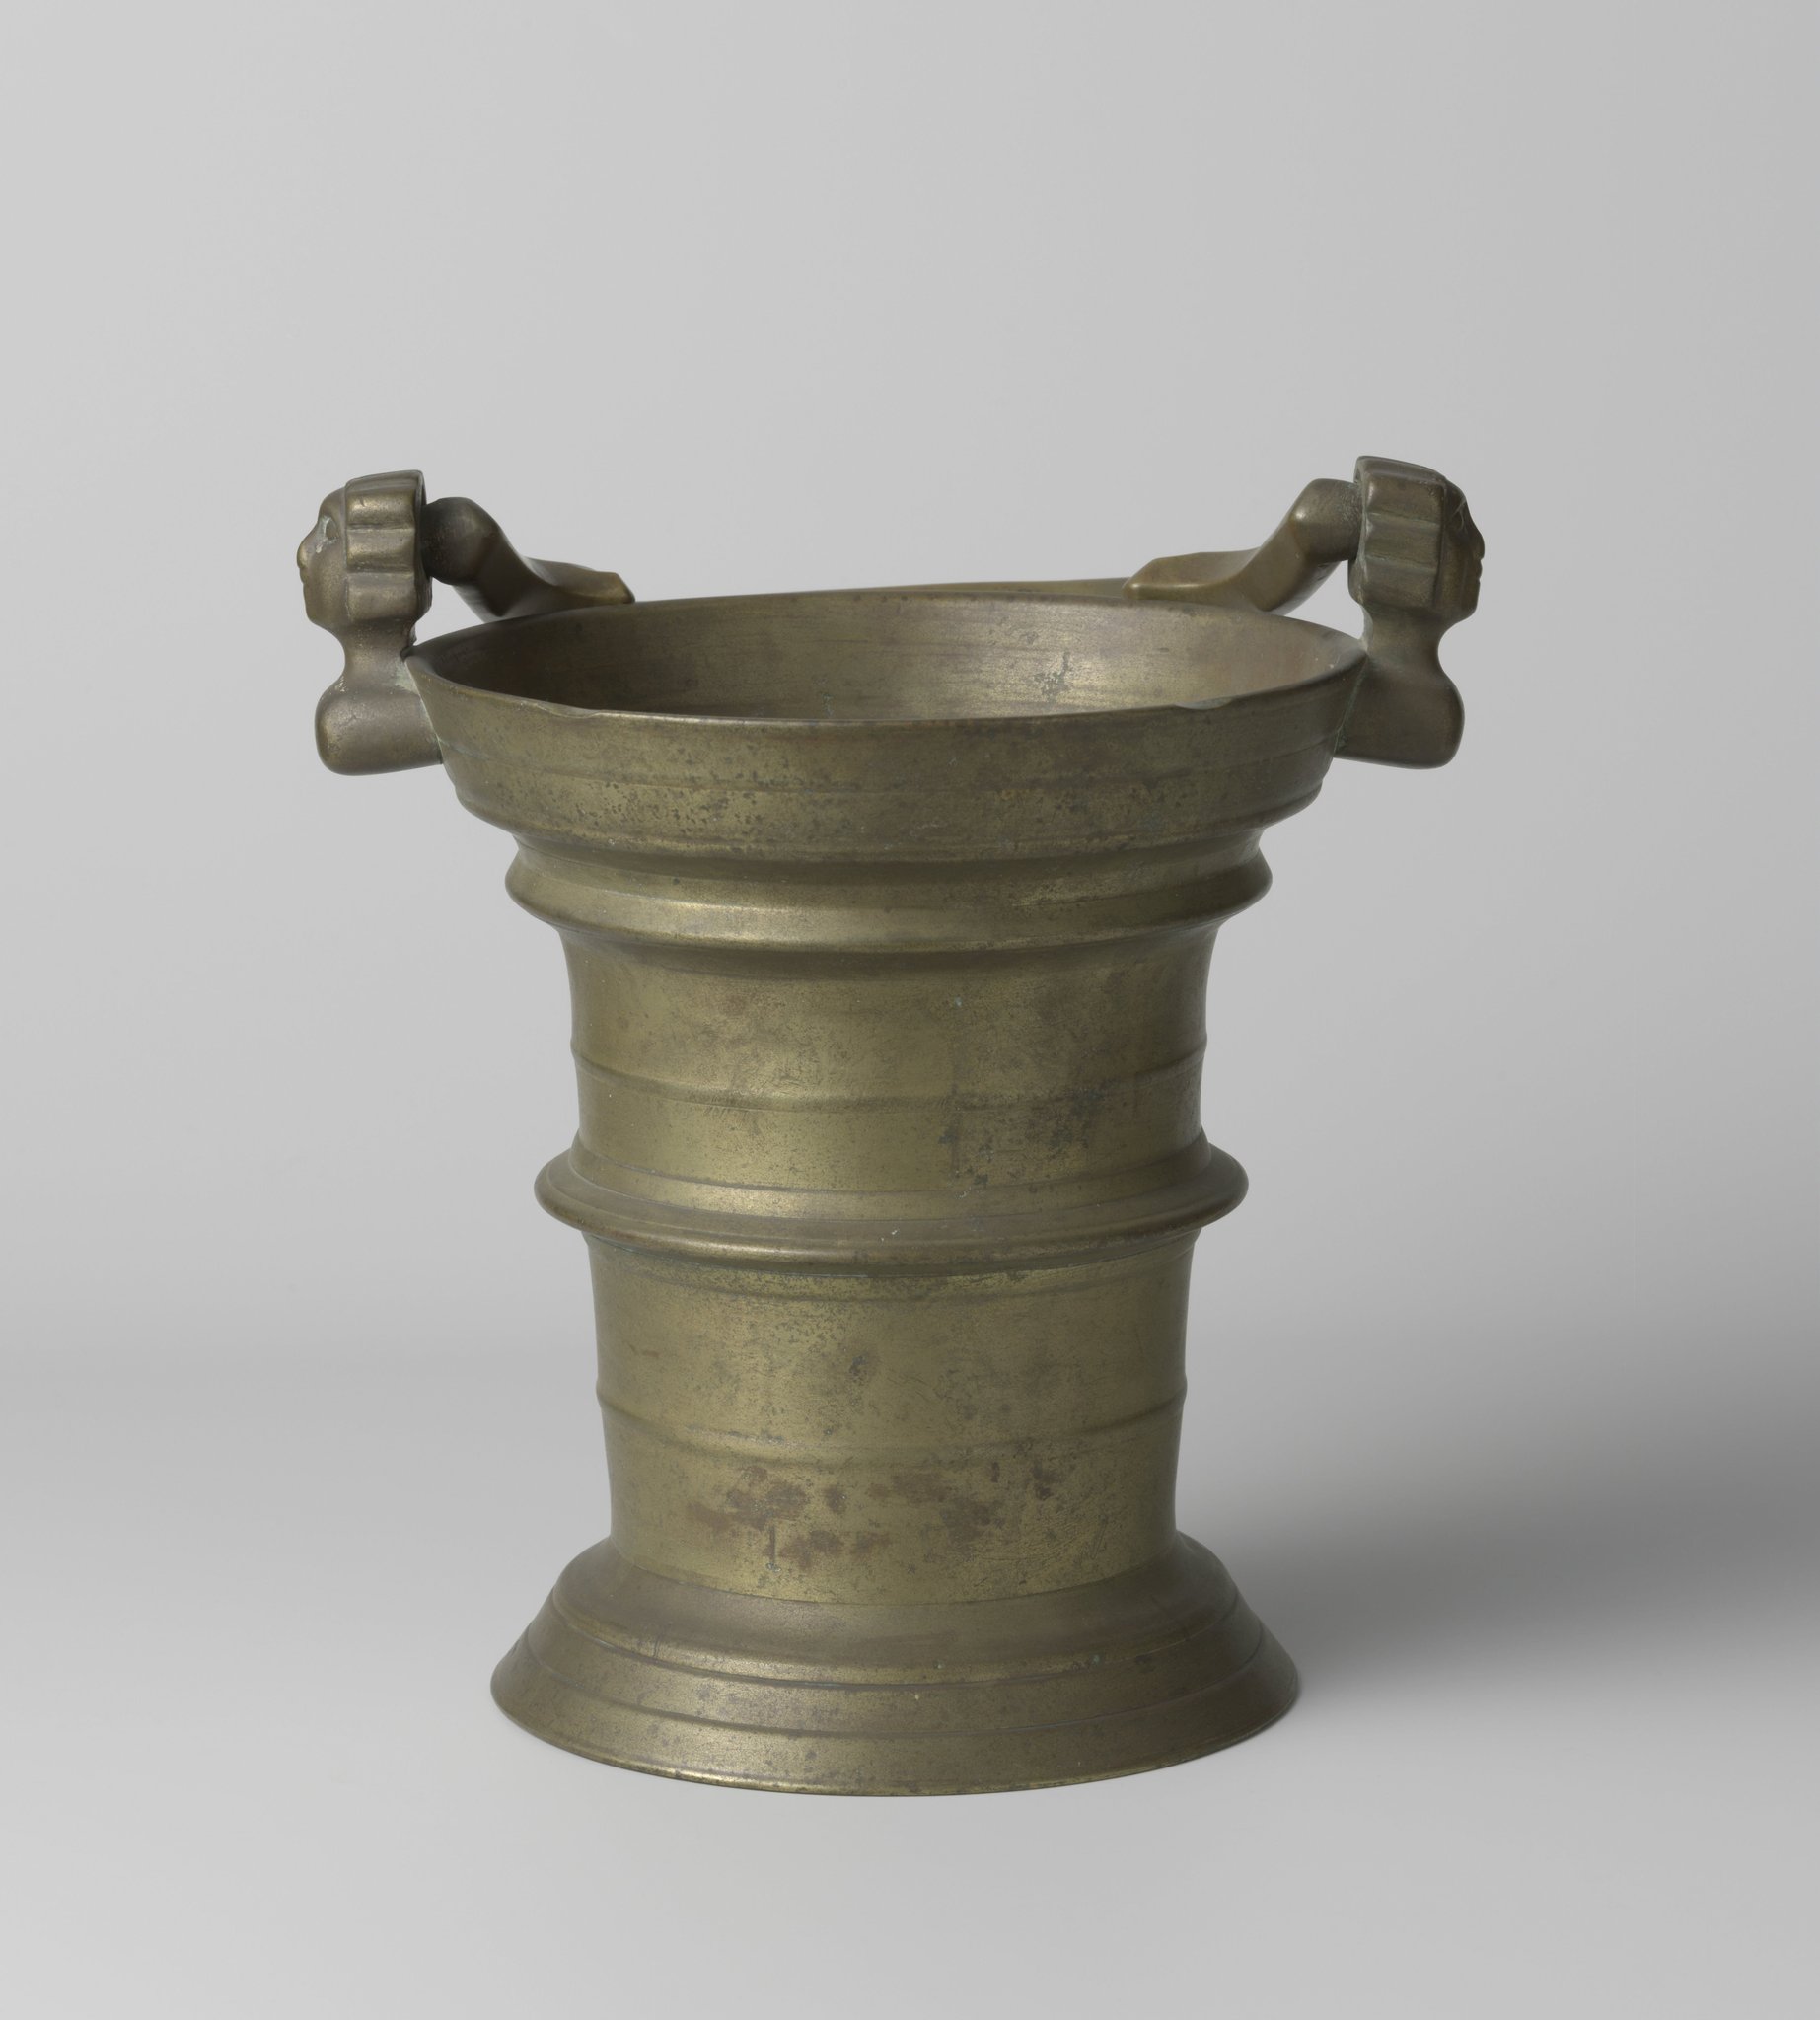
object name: aspersorium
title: Wijwateremmer, rond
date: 1450-1500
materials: brass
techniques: casting, riveted, turning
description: Het voorwerp is samengesteld uit de volgende delen: de emmer (gegoten en afgedraaid), de twee aanzetstukken (gegoten en aan de emmer geklonken), het hengsel (gegoten). In de bodem bevindt zich aan de onderkant het centergat, dat is omgeven door twee keer twee ringprofielen. Voorts zijn zowel daar als op de voet als in de wand op resp. 3, 4 en 5 plaatsen de restanten zichtbaar van de pennen, waarmee de gietkern was vastgezet en waardoor de wand een gelijkmatige dikte heeft verkregen. De emmer staat op een schuin aflopende geprofileerde holle voet. De wand van de emmer is in het midden versierd met een forse geprofileerde enigszins spitse rib, en met een rib op de bovenste en onderste helft. De overgang naar de geprofileerde uitkragende rand wordt eveneens gevormd door een forse min of meer spitse rib. De aanzetstukken zijn borstbeelden in de vorm van een vrouw. Het in doorsnee min of meer ruitvormige hengsel heeft de vorm van een driepas, waarvan de bovenkant is afgeplat. Aldaar is er een stuk ingezet.